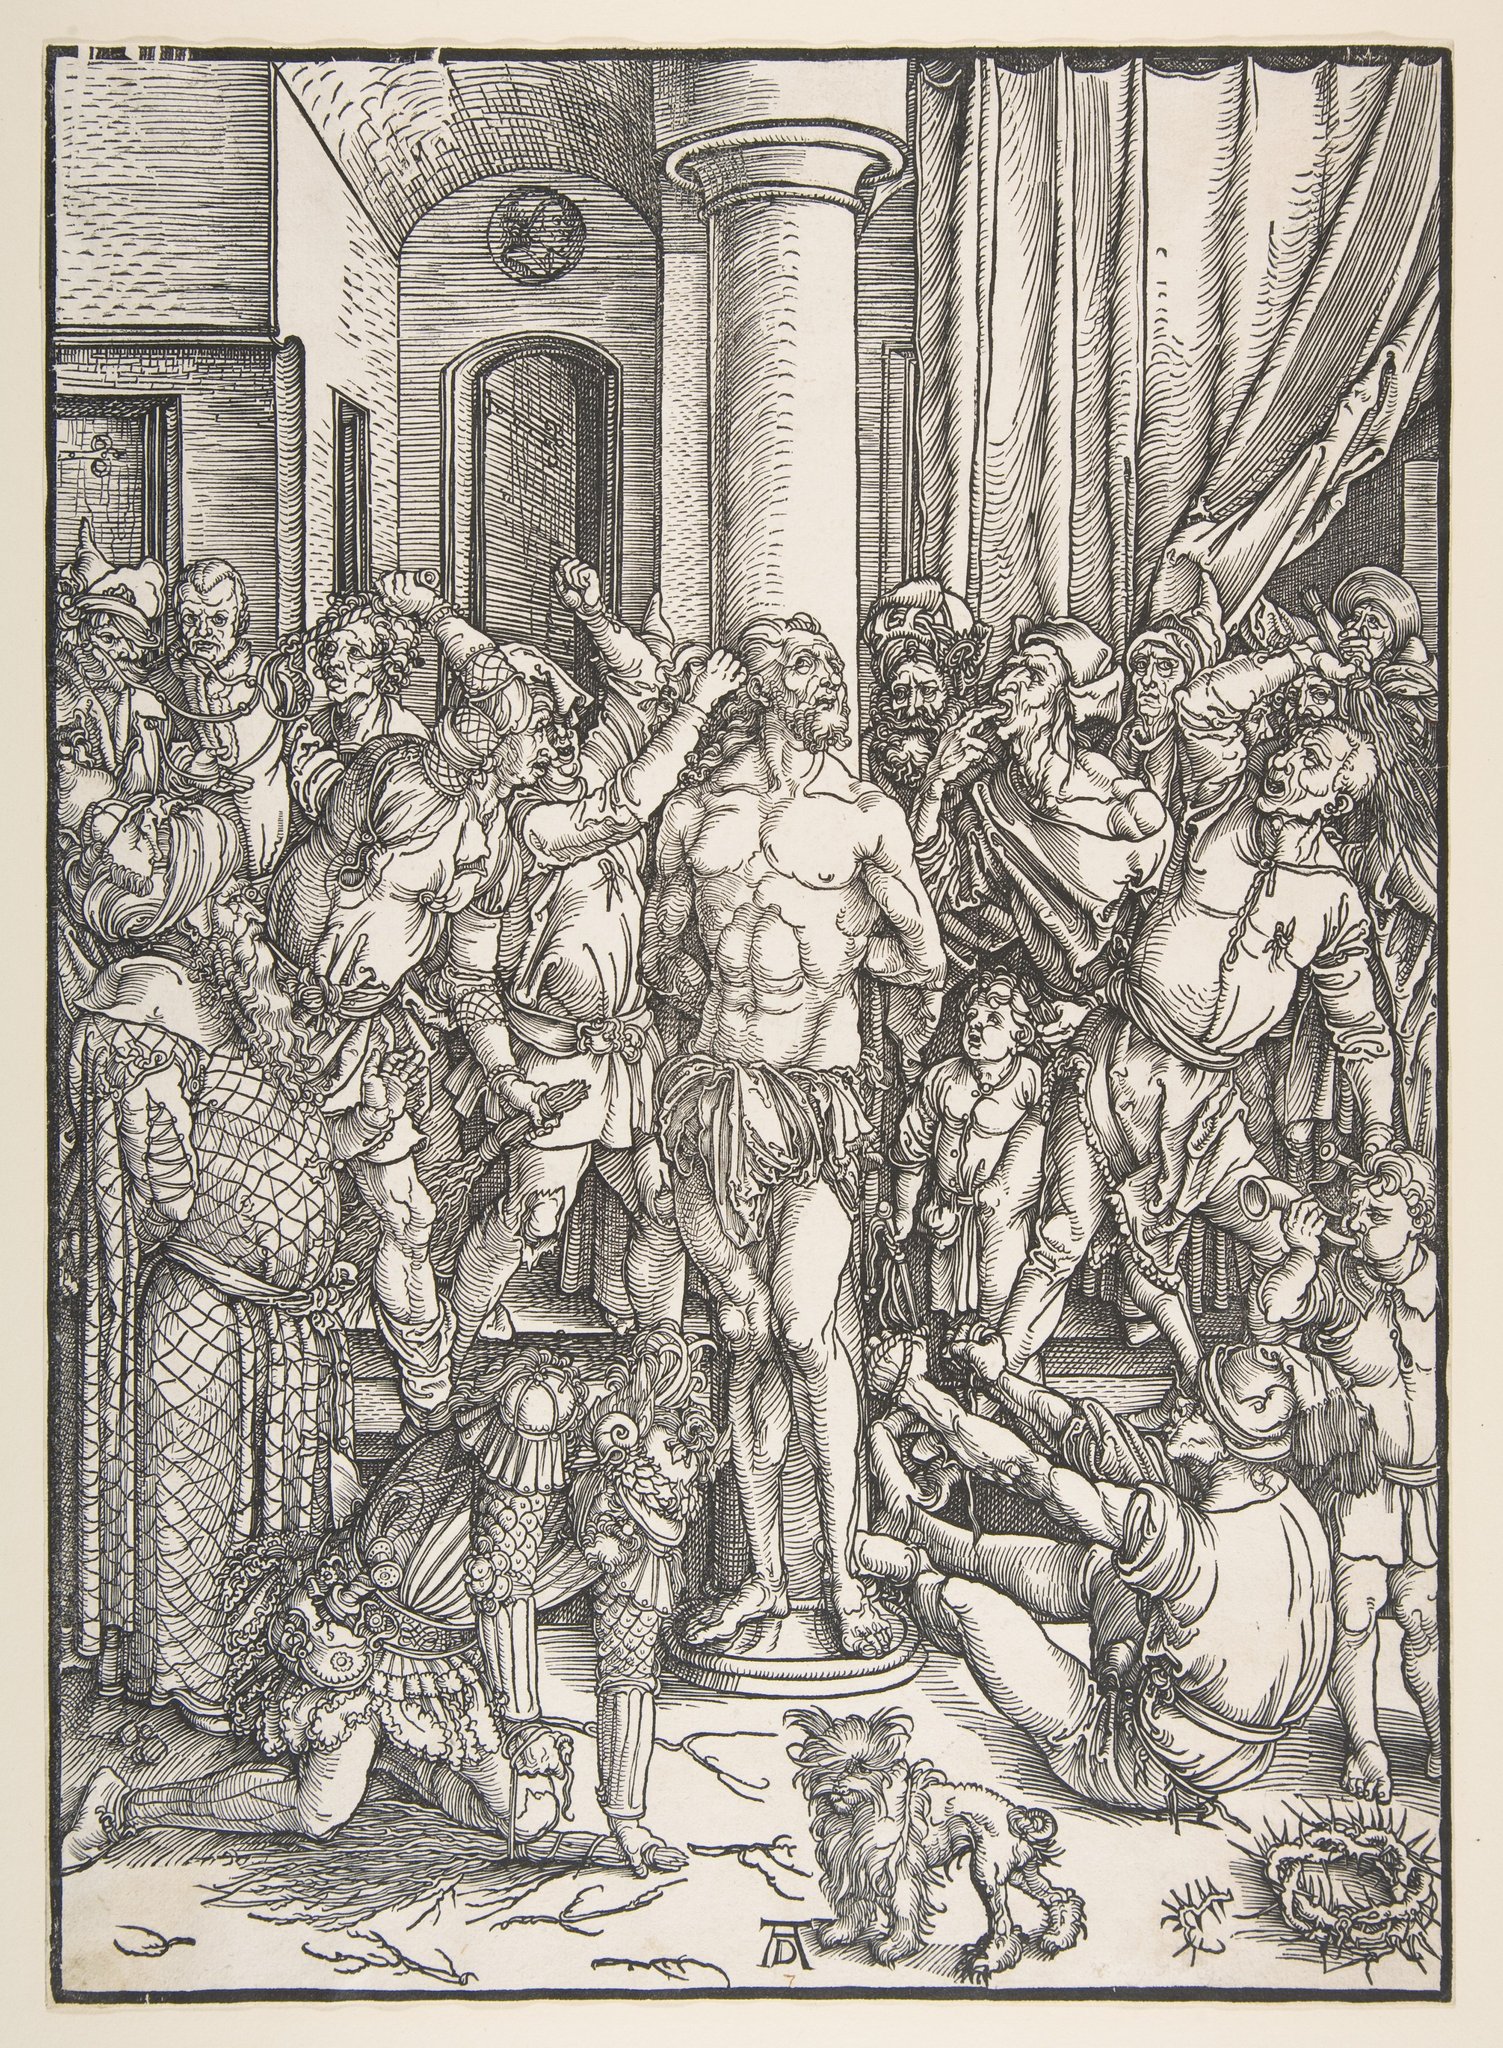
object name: print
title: The Scourging of Christ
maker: albrecht dürer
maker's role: artist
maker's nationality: german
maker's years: 1471-1528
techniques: woodcut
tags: men,dogs,christ